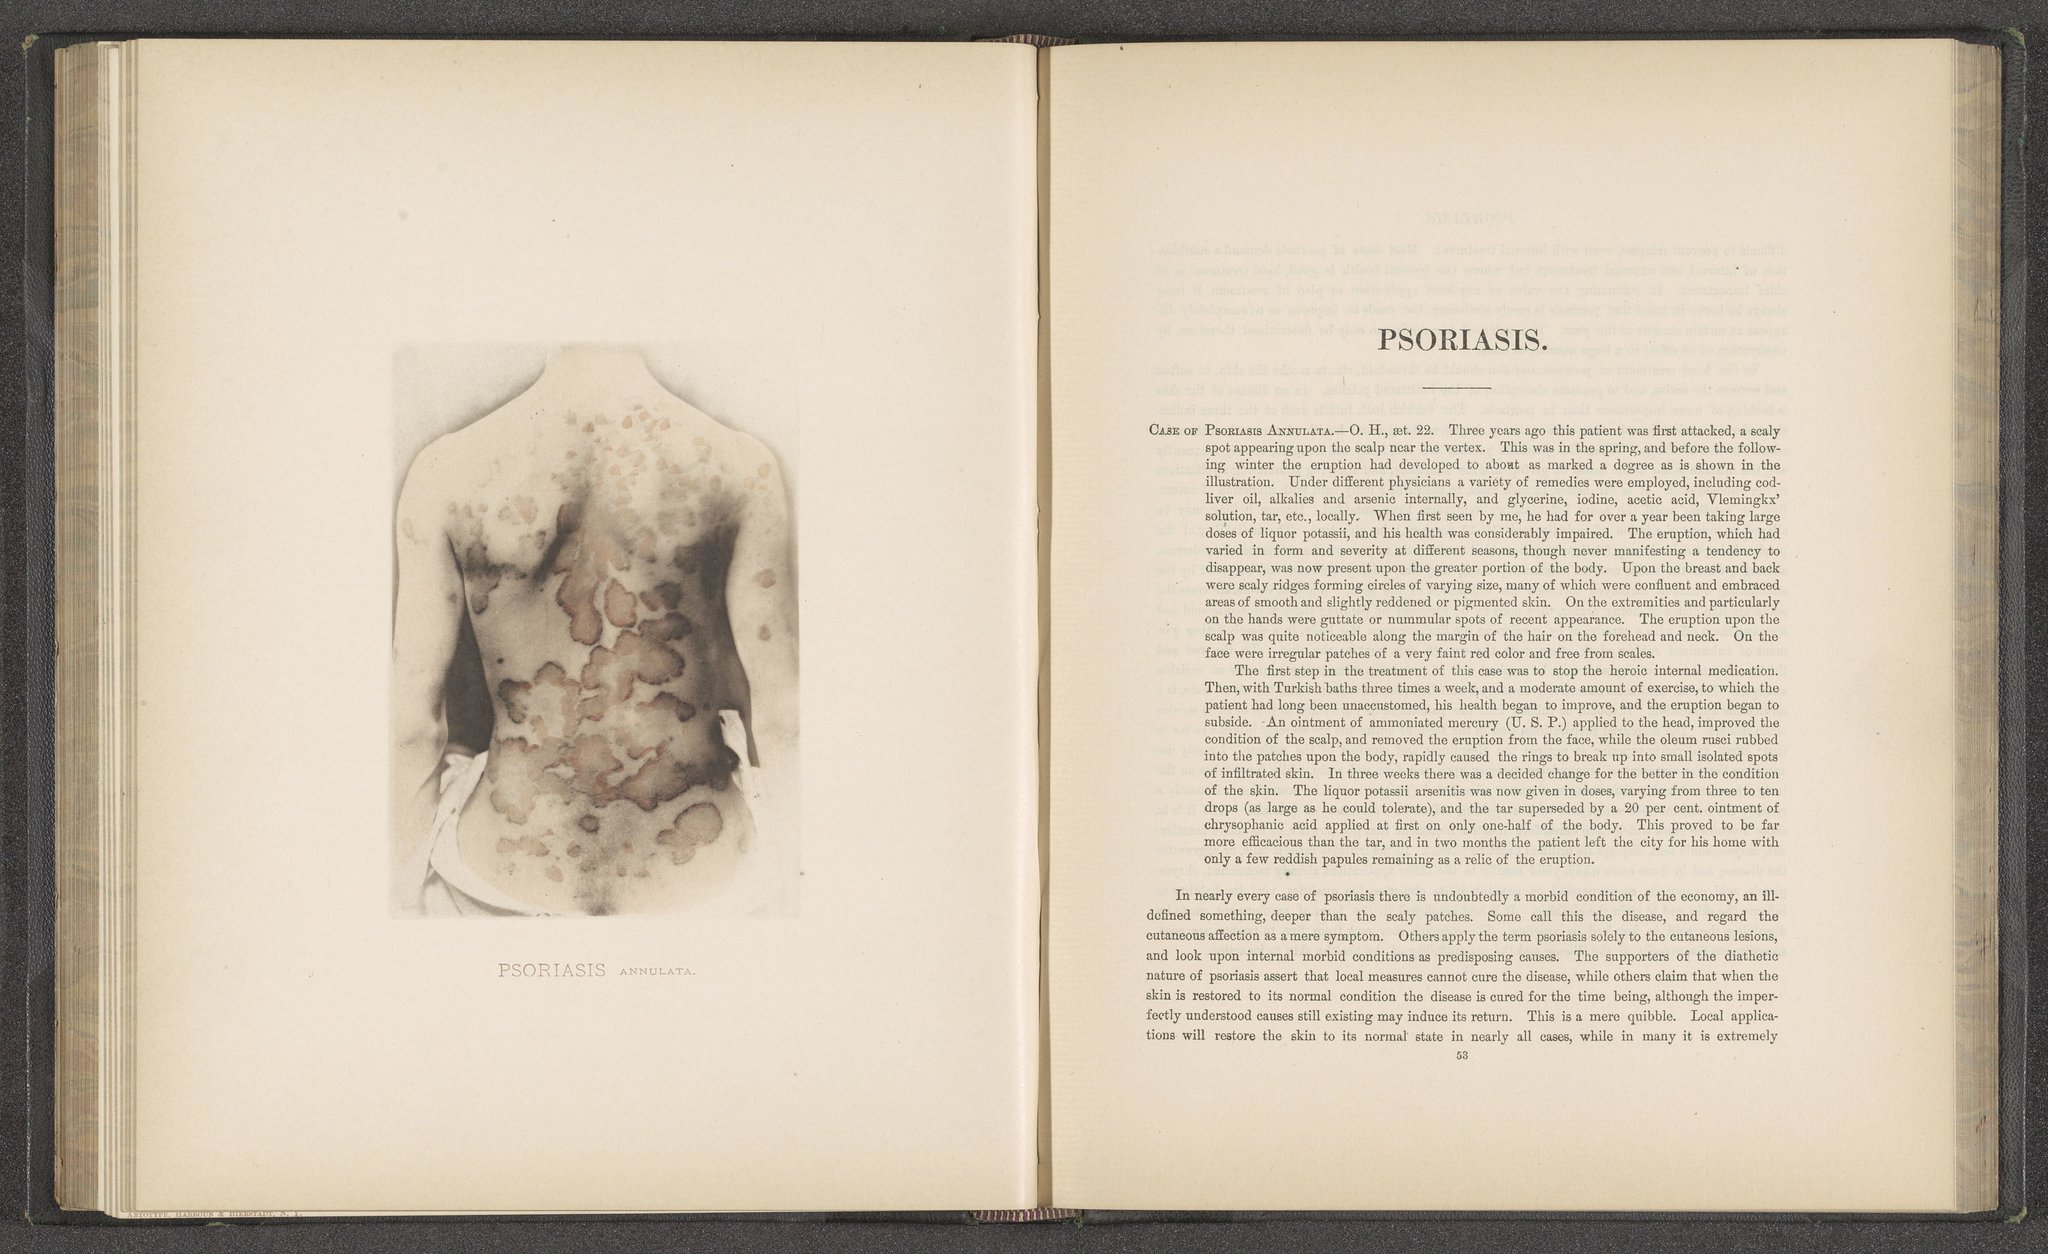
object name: page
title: Patiënt lijdend aan de huidziekte 'psoriasis annulata'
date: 1870-1881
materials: paper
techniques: photograph, hand coloring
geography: new york city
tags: skin and venereal diseases, adult man, back